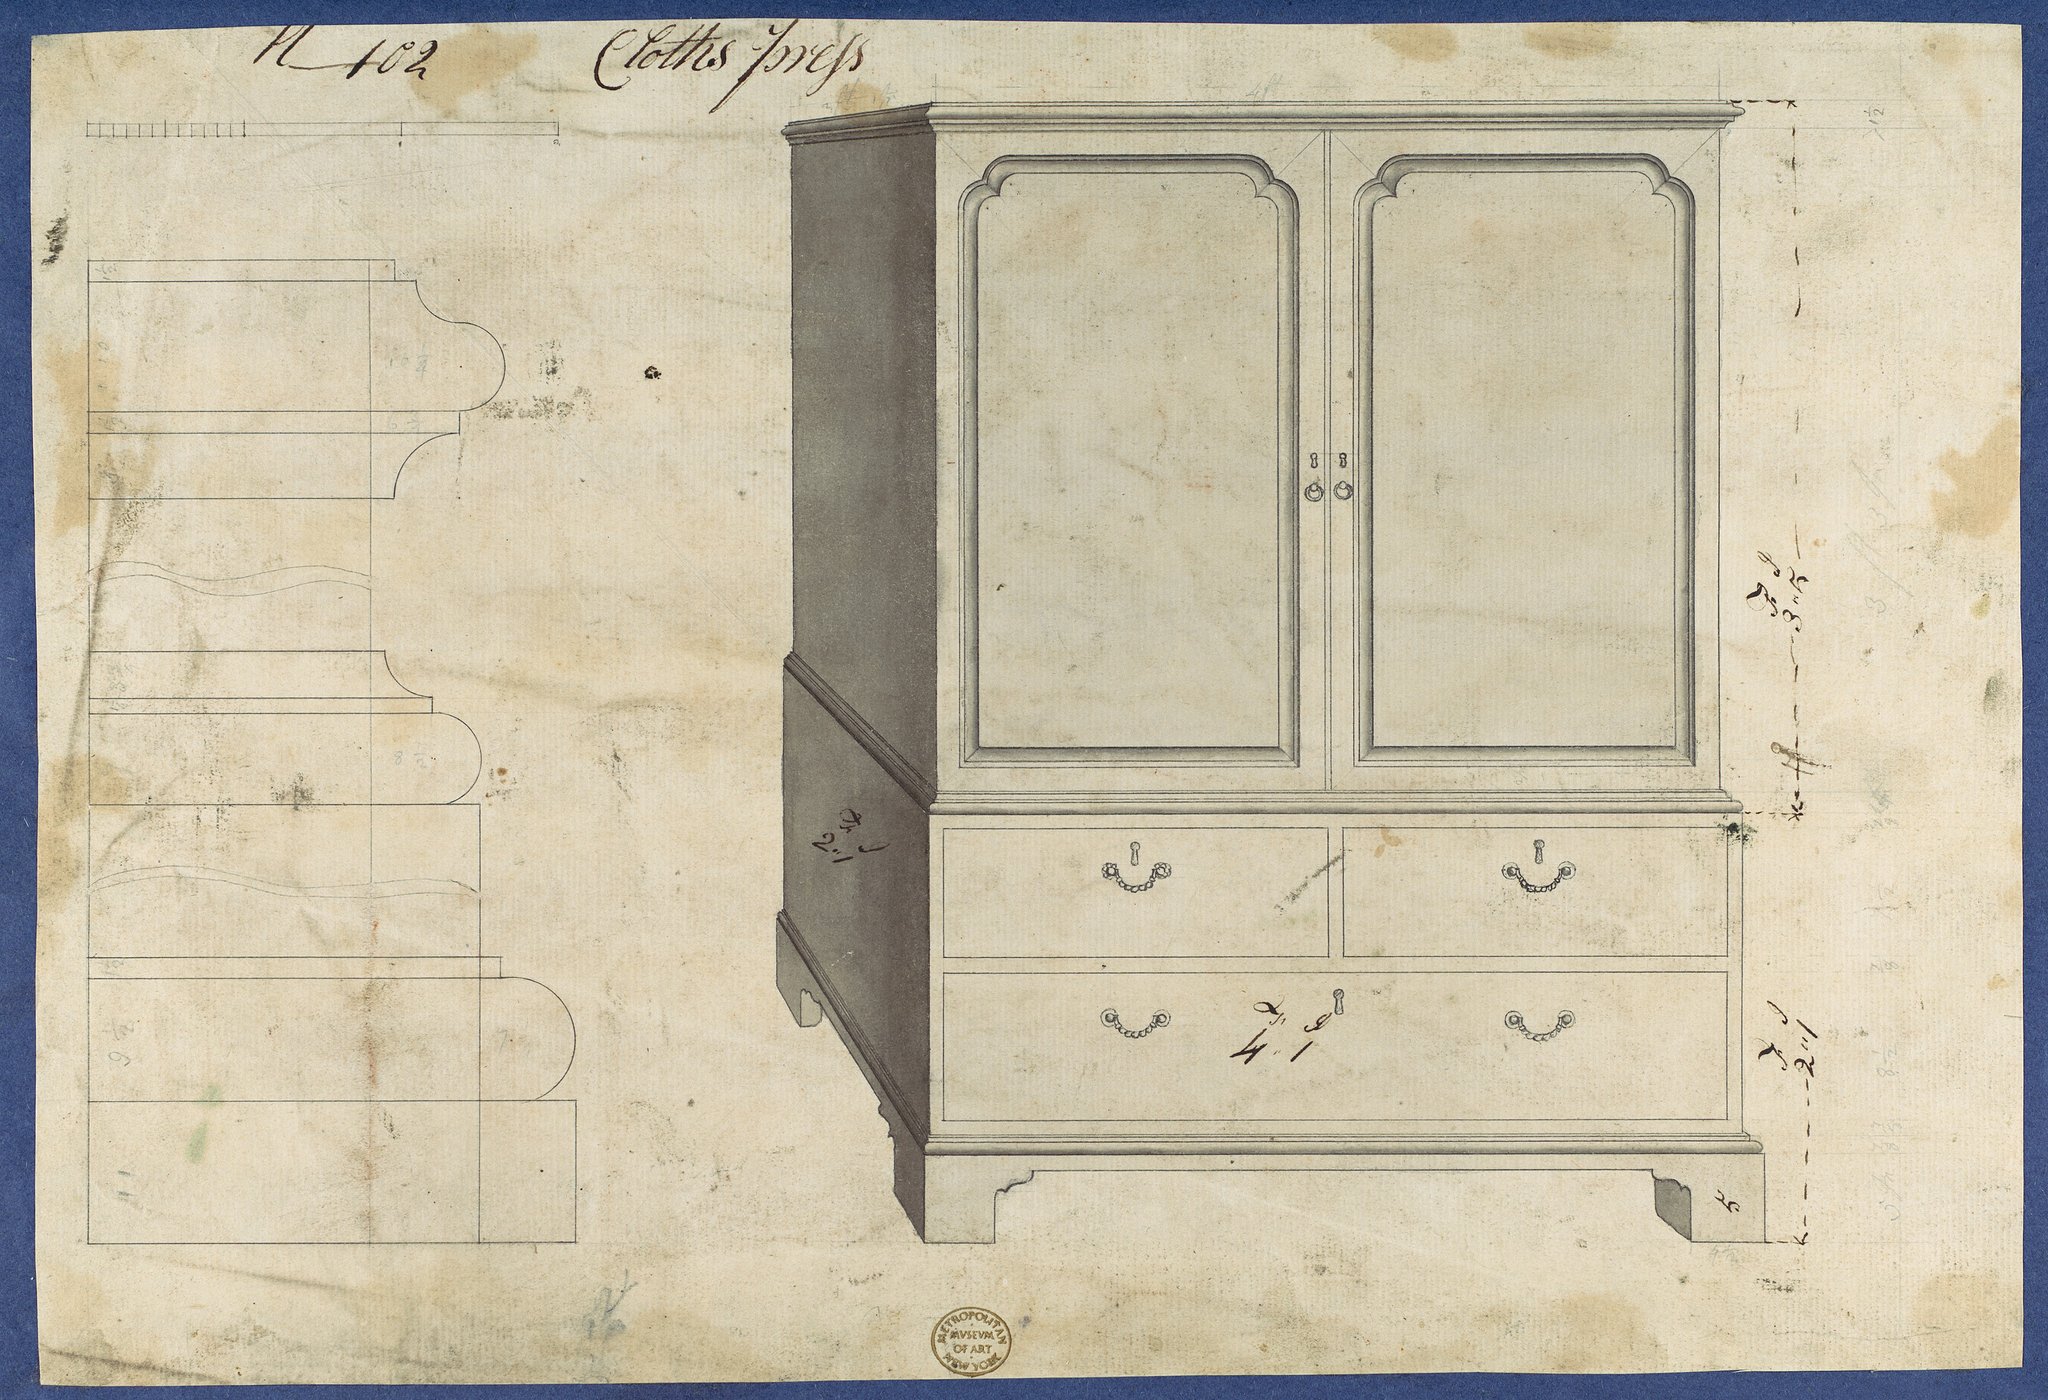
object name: drawing ornament architecture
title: Clothes Press, from Chippendale Drawings, Vol. II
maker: thomas chippendale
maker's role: artist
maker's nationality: british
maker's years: 1718-1779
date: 1753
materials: ink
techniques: wash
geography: london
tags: furniture